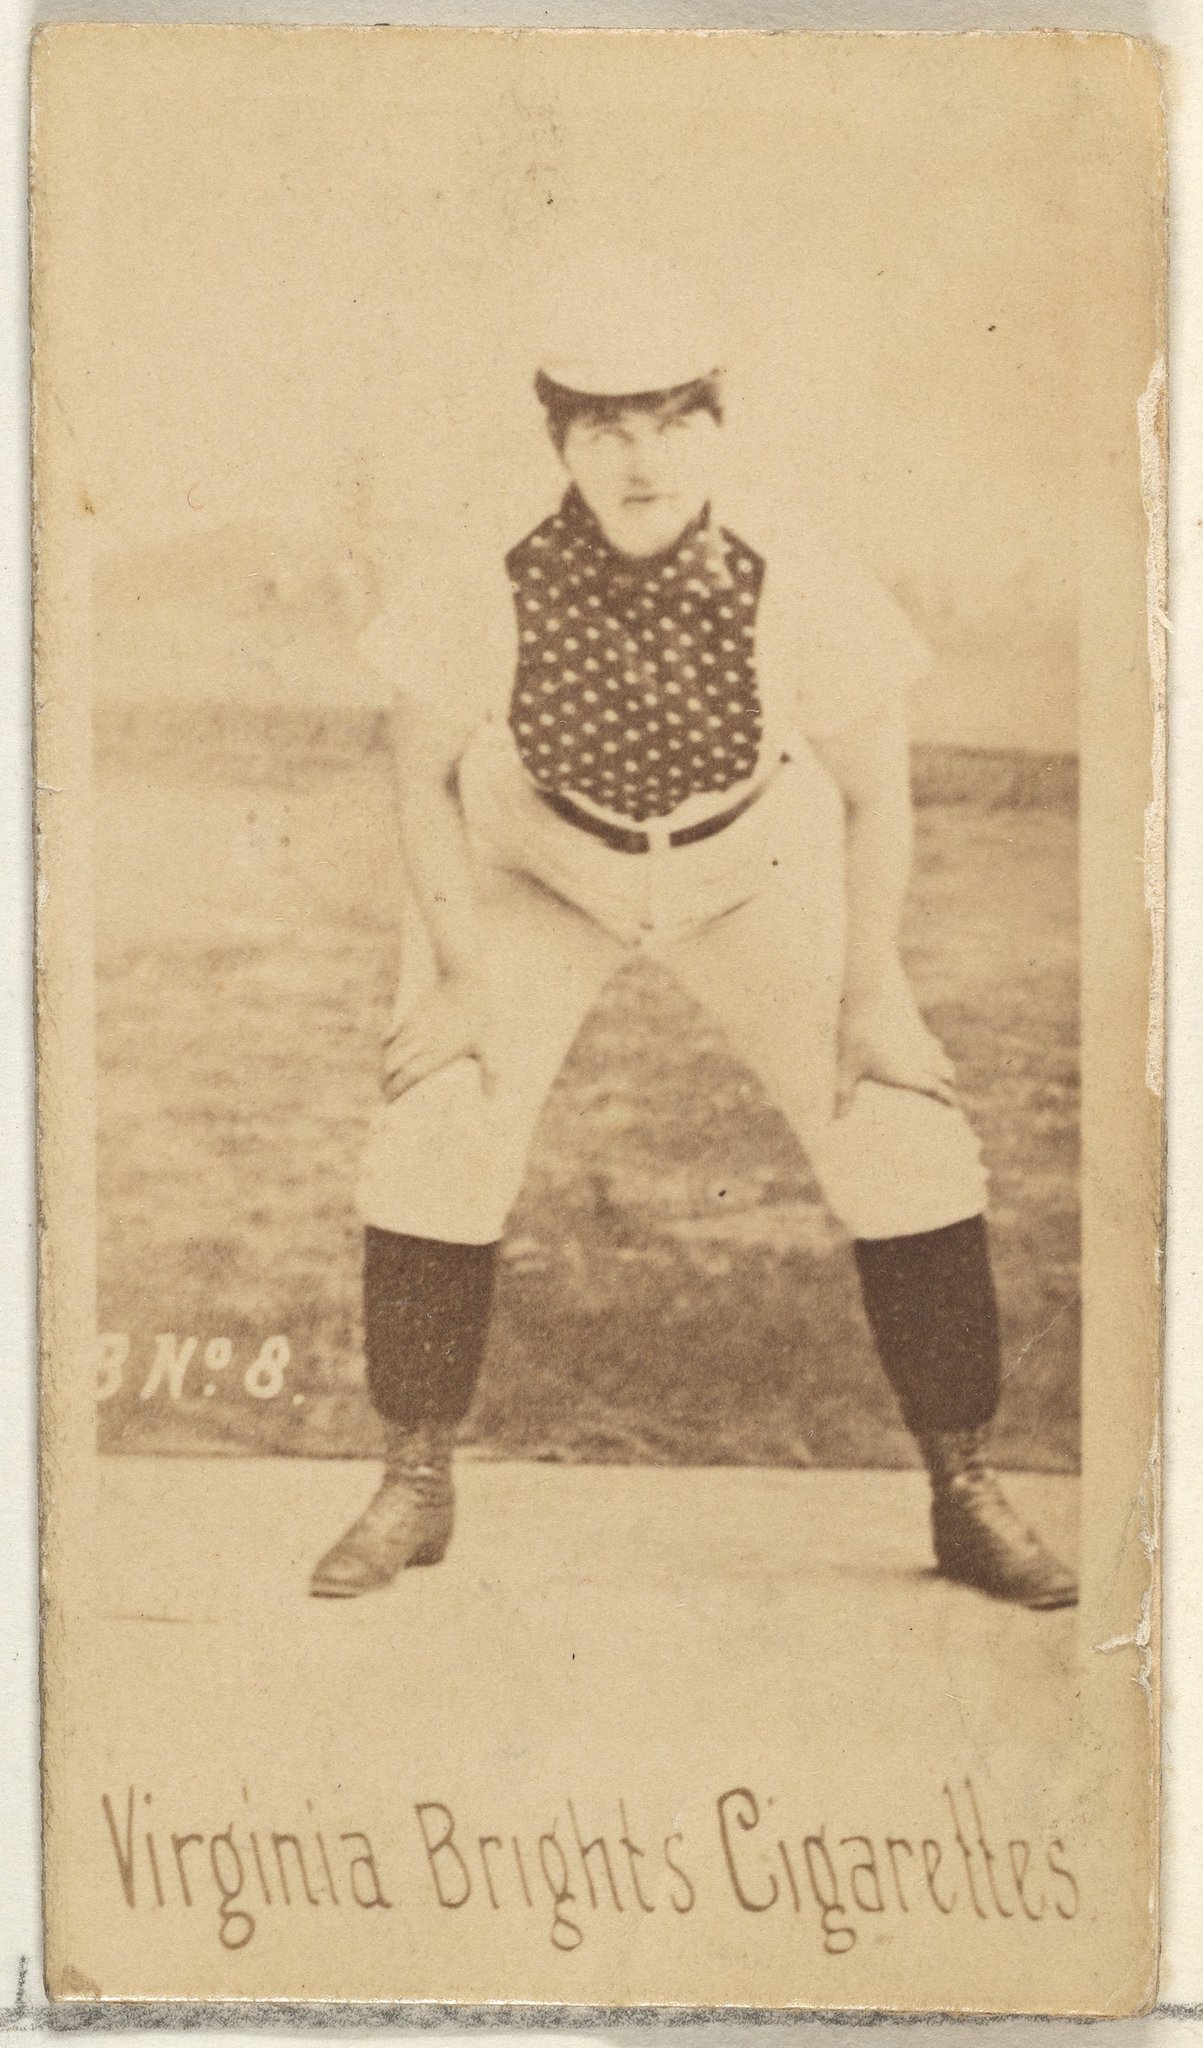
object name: baseball card, photograph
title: Card 8, from the Girl Baseball Players series (N48, Type 1) for Virginia Brights Cigarettes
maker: allen & ginter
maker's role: publisher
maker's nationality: american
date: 1886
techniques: albumen silver print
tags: portraits,women,baseball,athletes